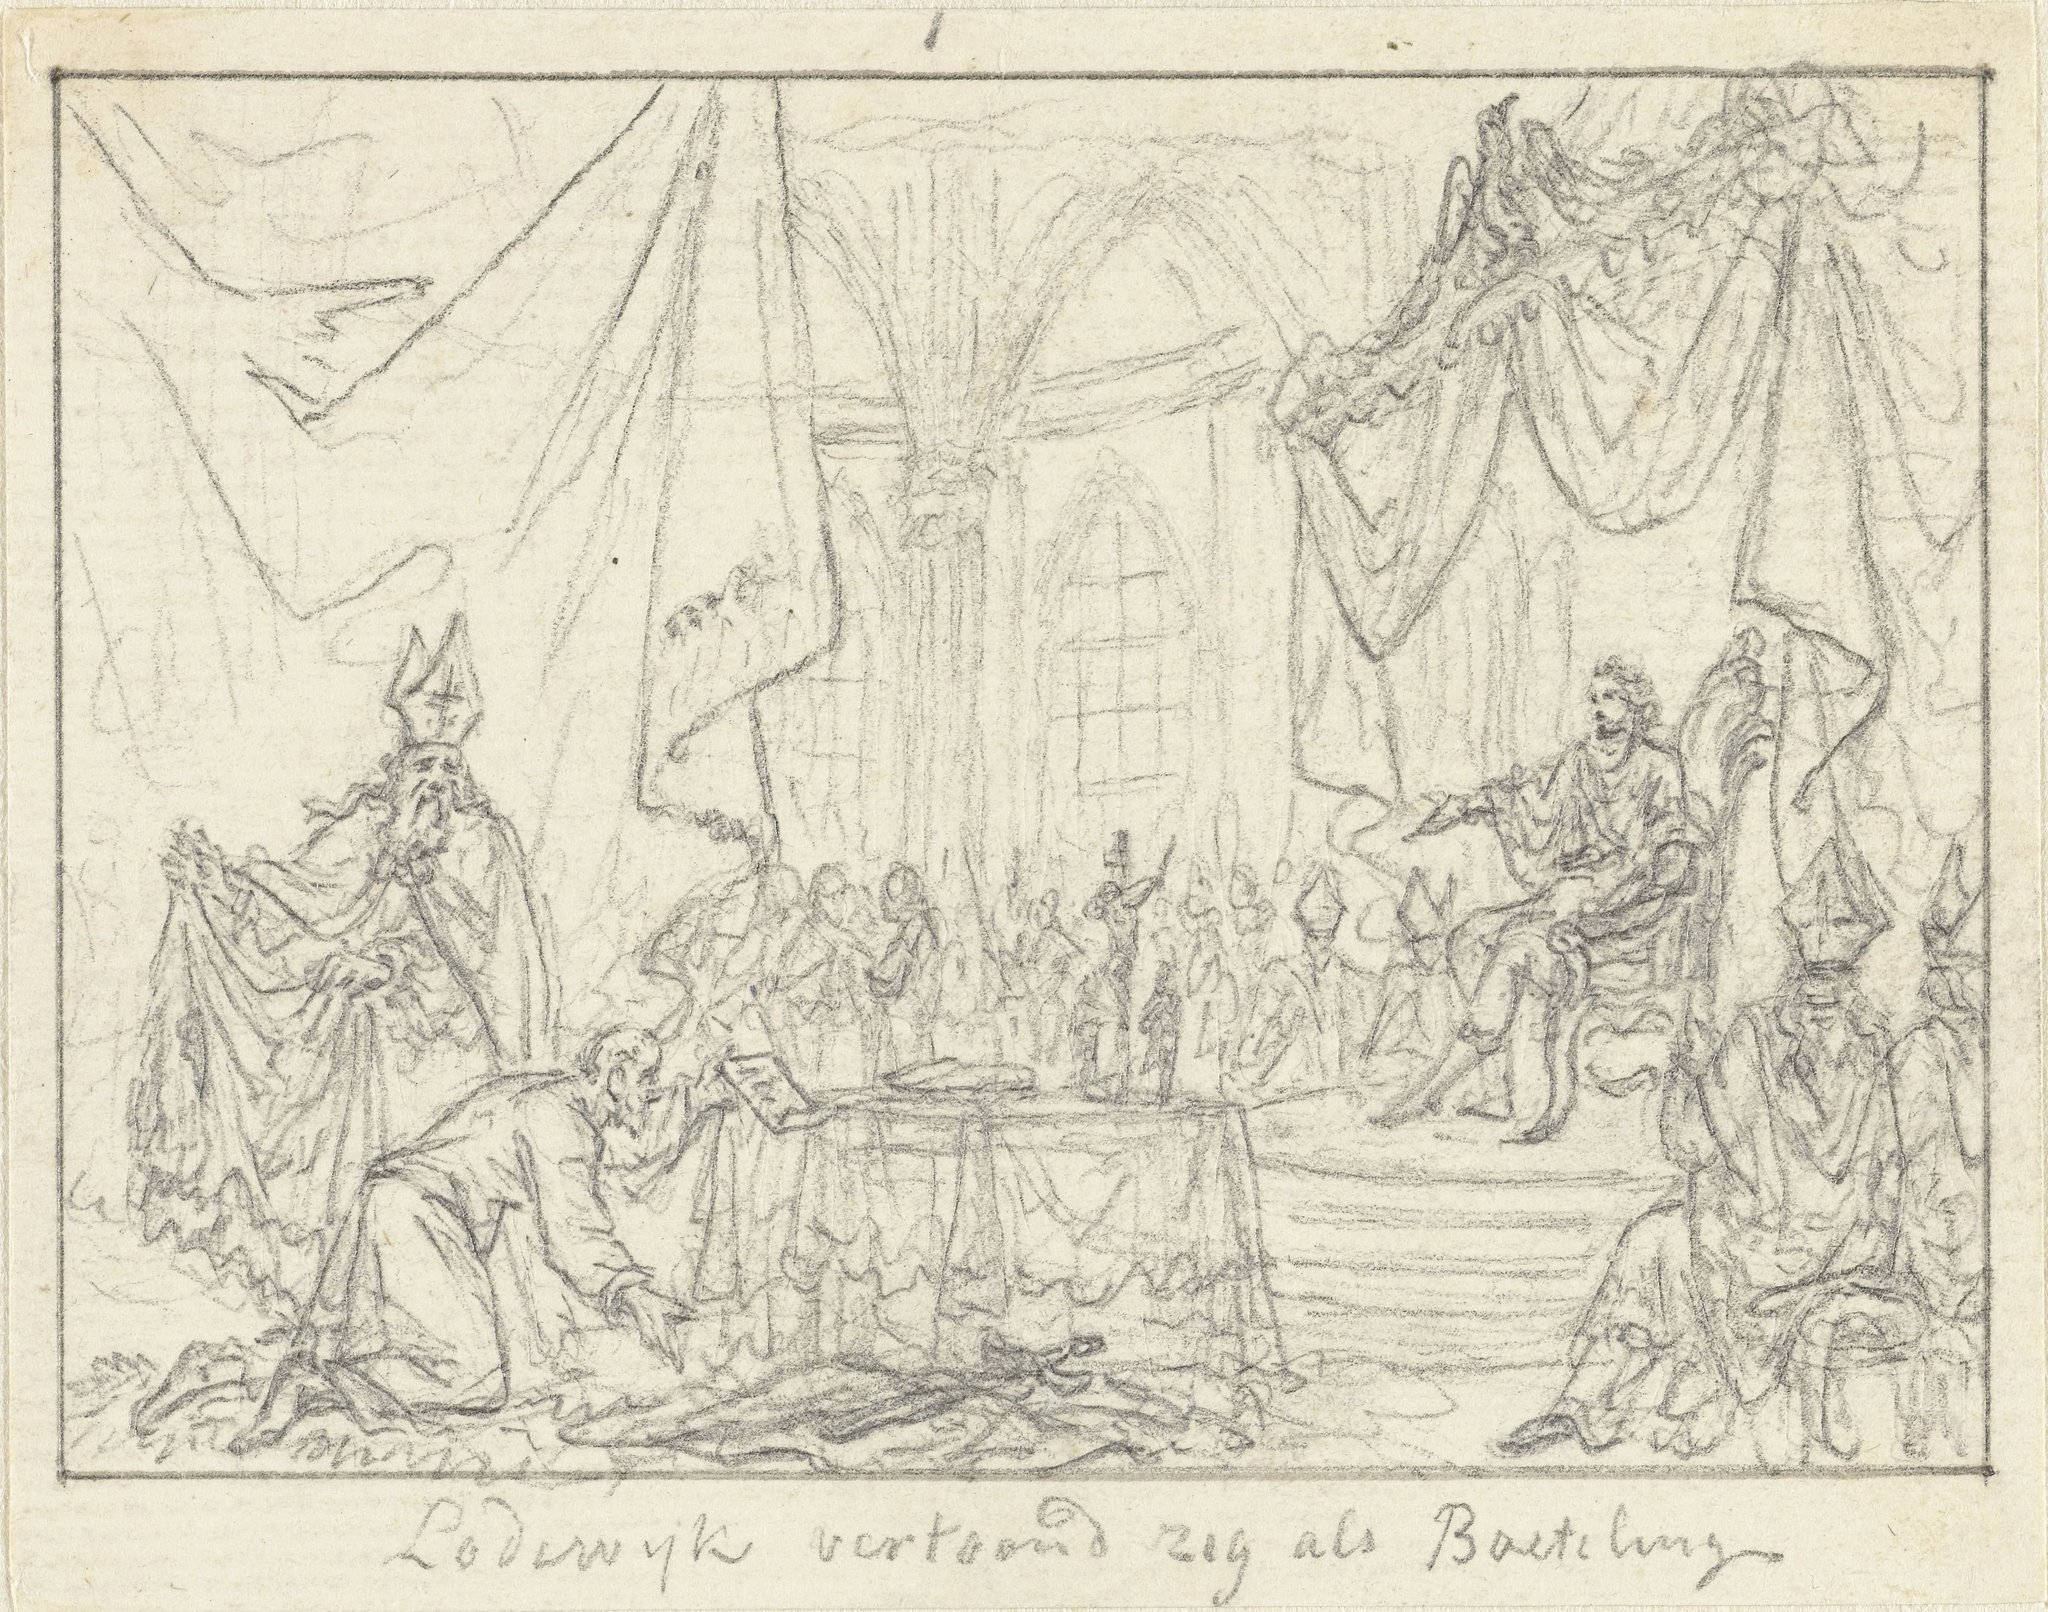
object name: drawing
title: Lodewijk (de Vrome?) als boeteling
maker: simon fokke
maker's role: draughtsman, print maker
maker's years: 1712-1784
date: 1722-1784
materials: paper, pencil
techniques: pouncing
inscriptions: annotation: ‘lodewijk vertoont zig als boeteling (in handschrift van de kunstenaar)’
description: Lodewijk (de Vrome, 778-840?) als boeteling. Ontwerp voor een prent.